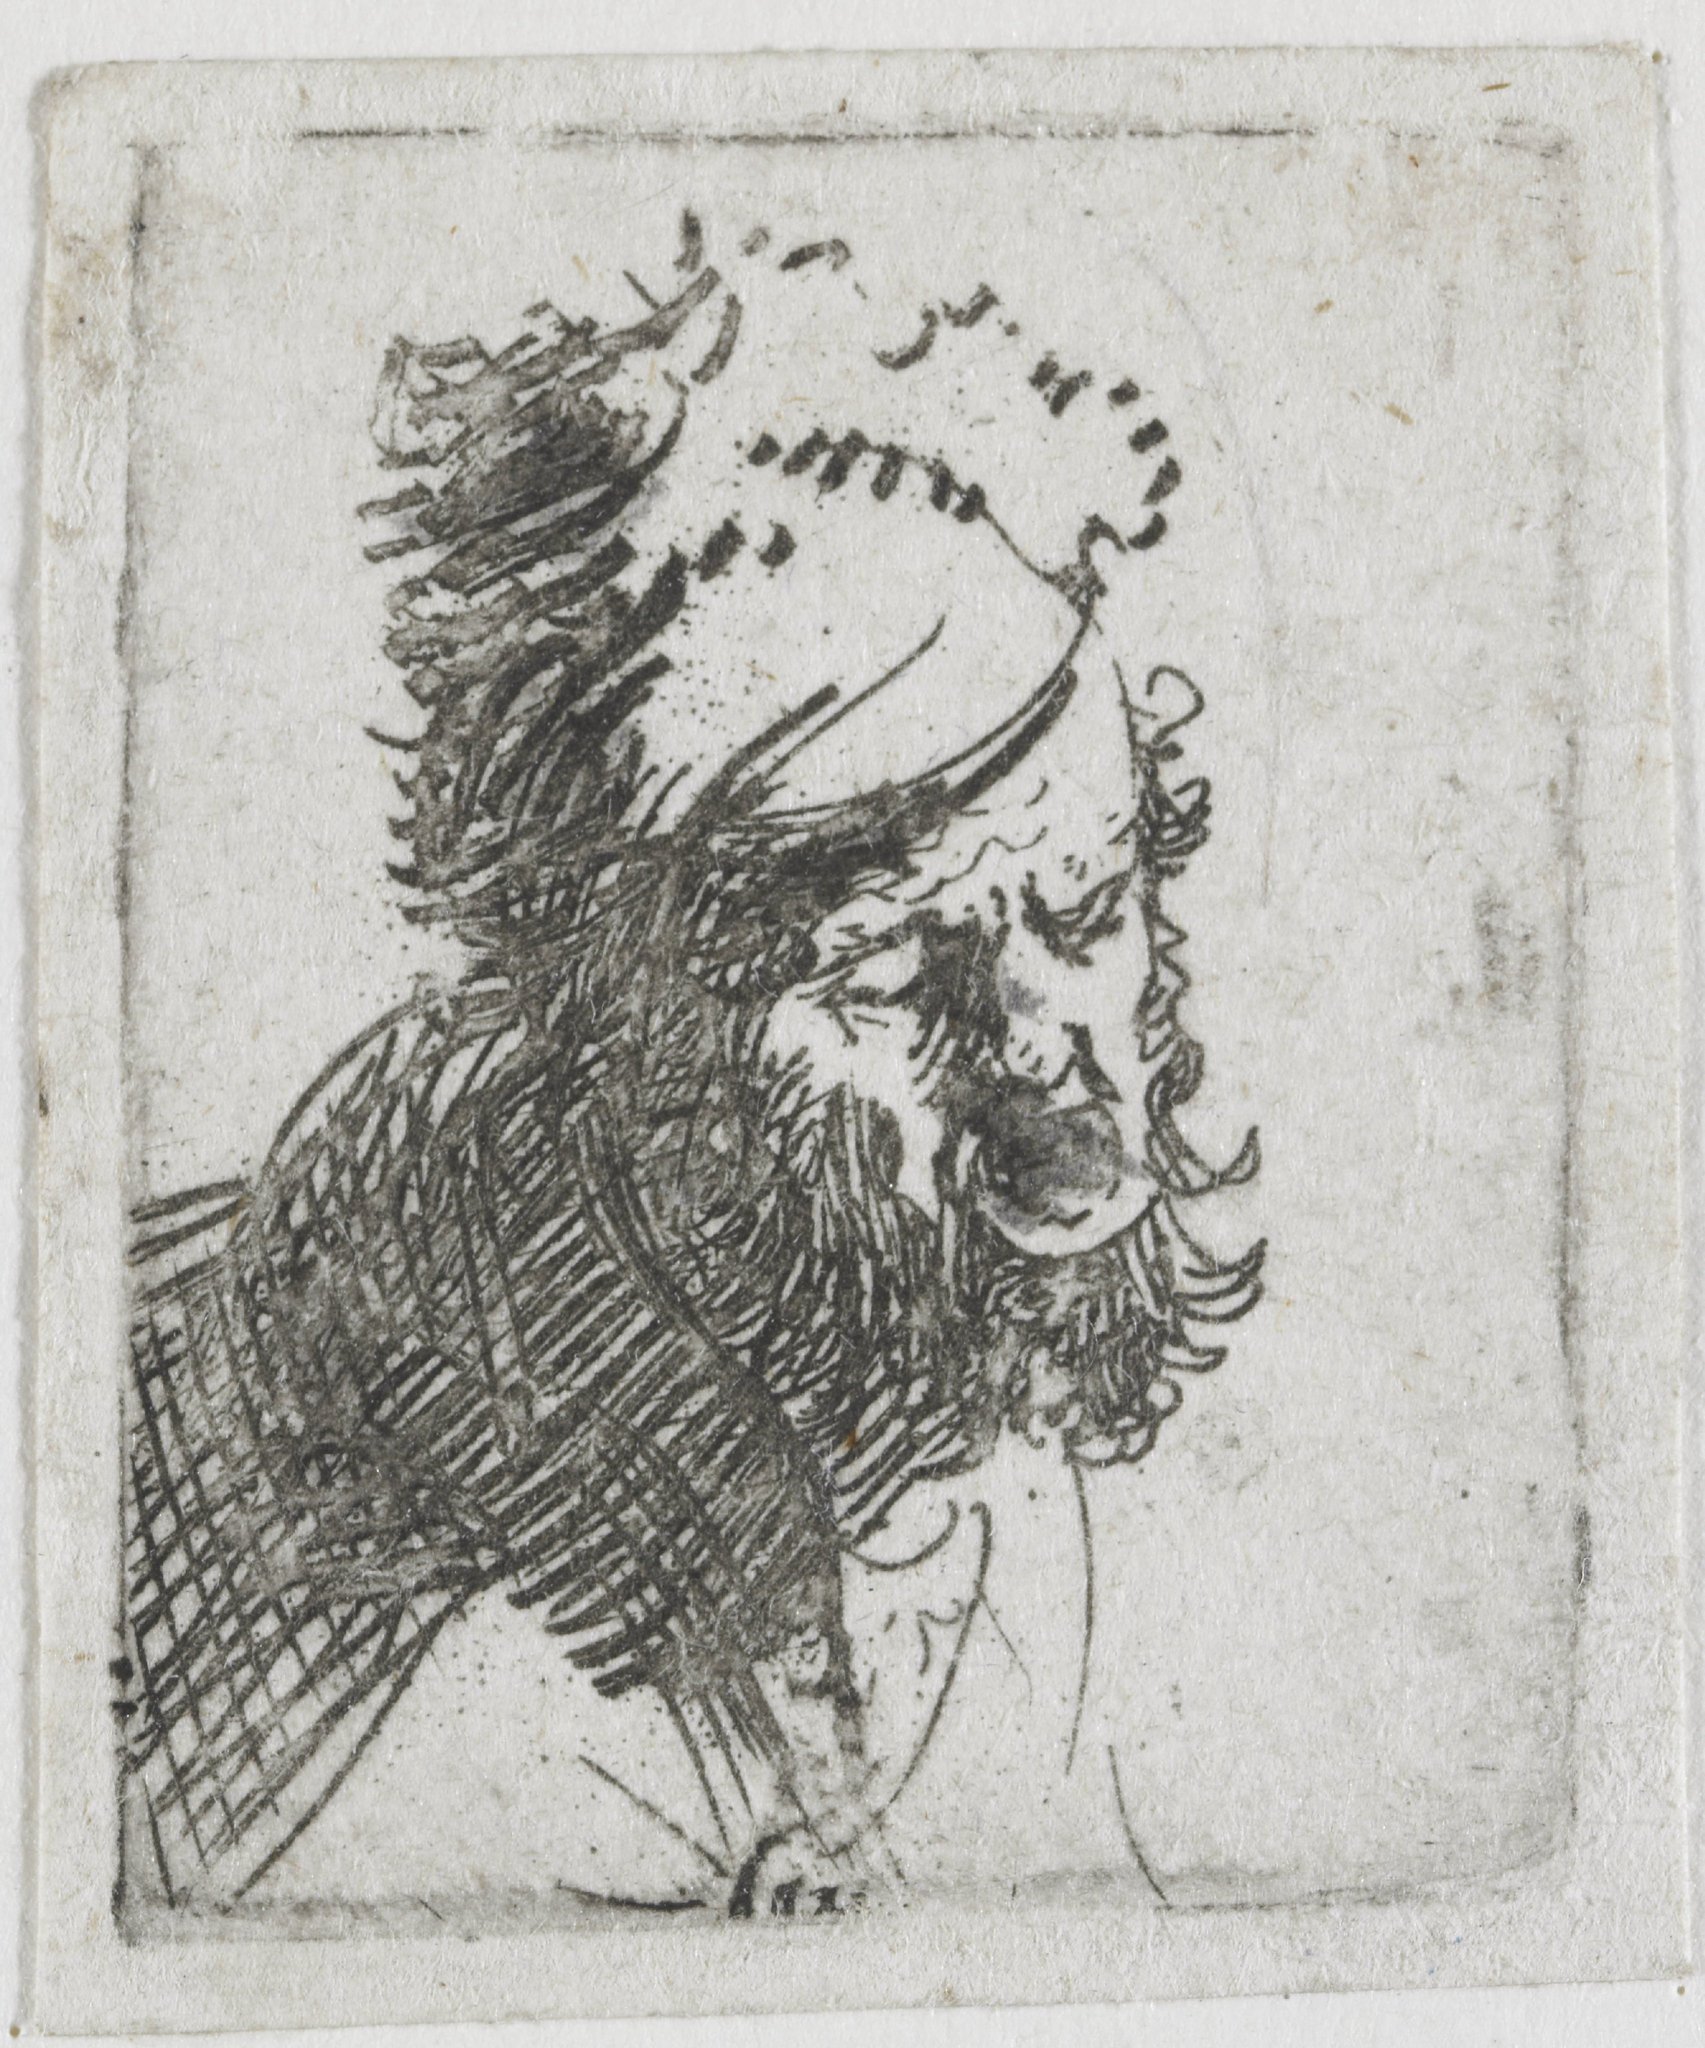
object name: print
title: Head of a man in a fur cap, crying out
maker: rembrandt van rijn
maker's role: draughtsman, painter, print maker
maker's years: 1606-1669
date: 1629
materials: paper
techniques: etching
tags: head-gear (with name)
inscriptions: mark: Lugt 2165